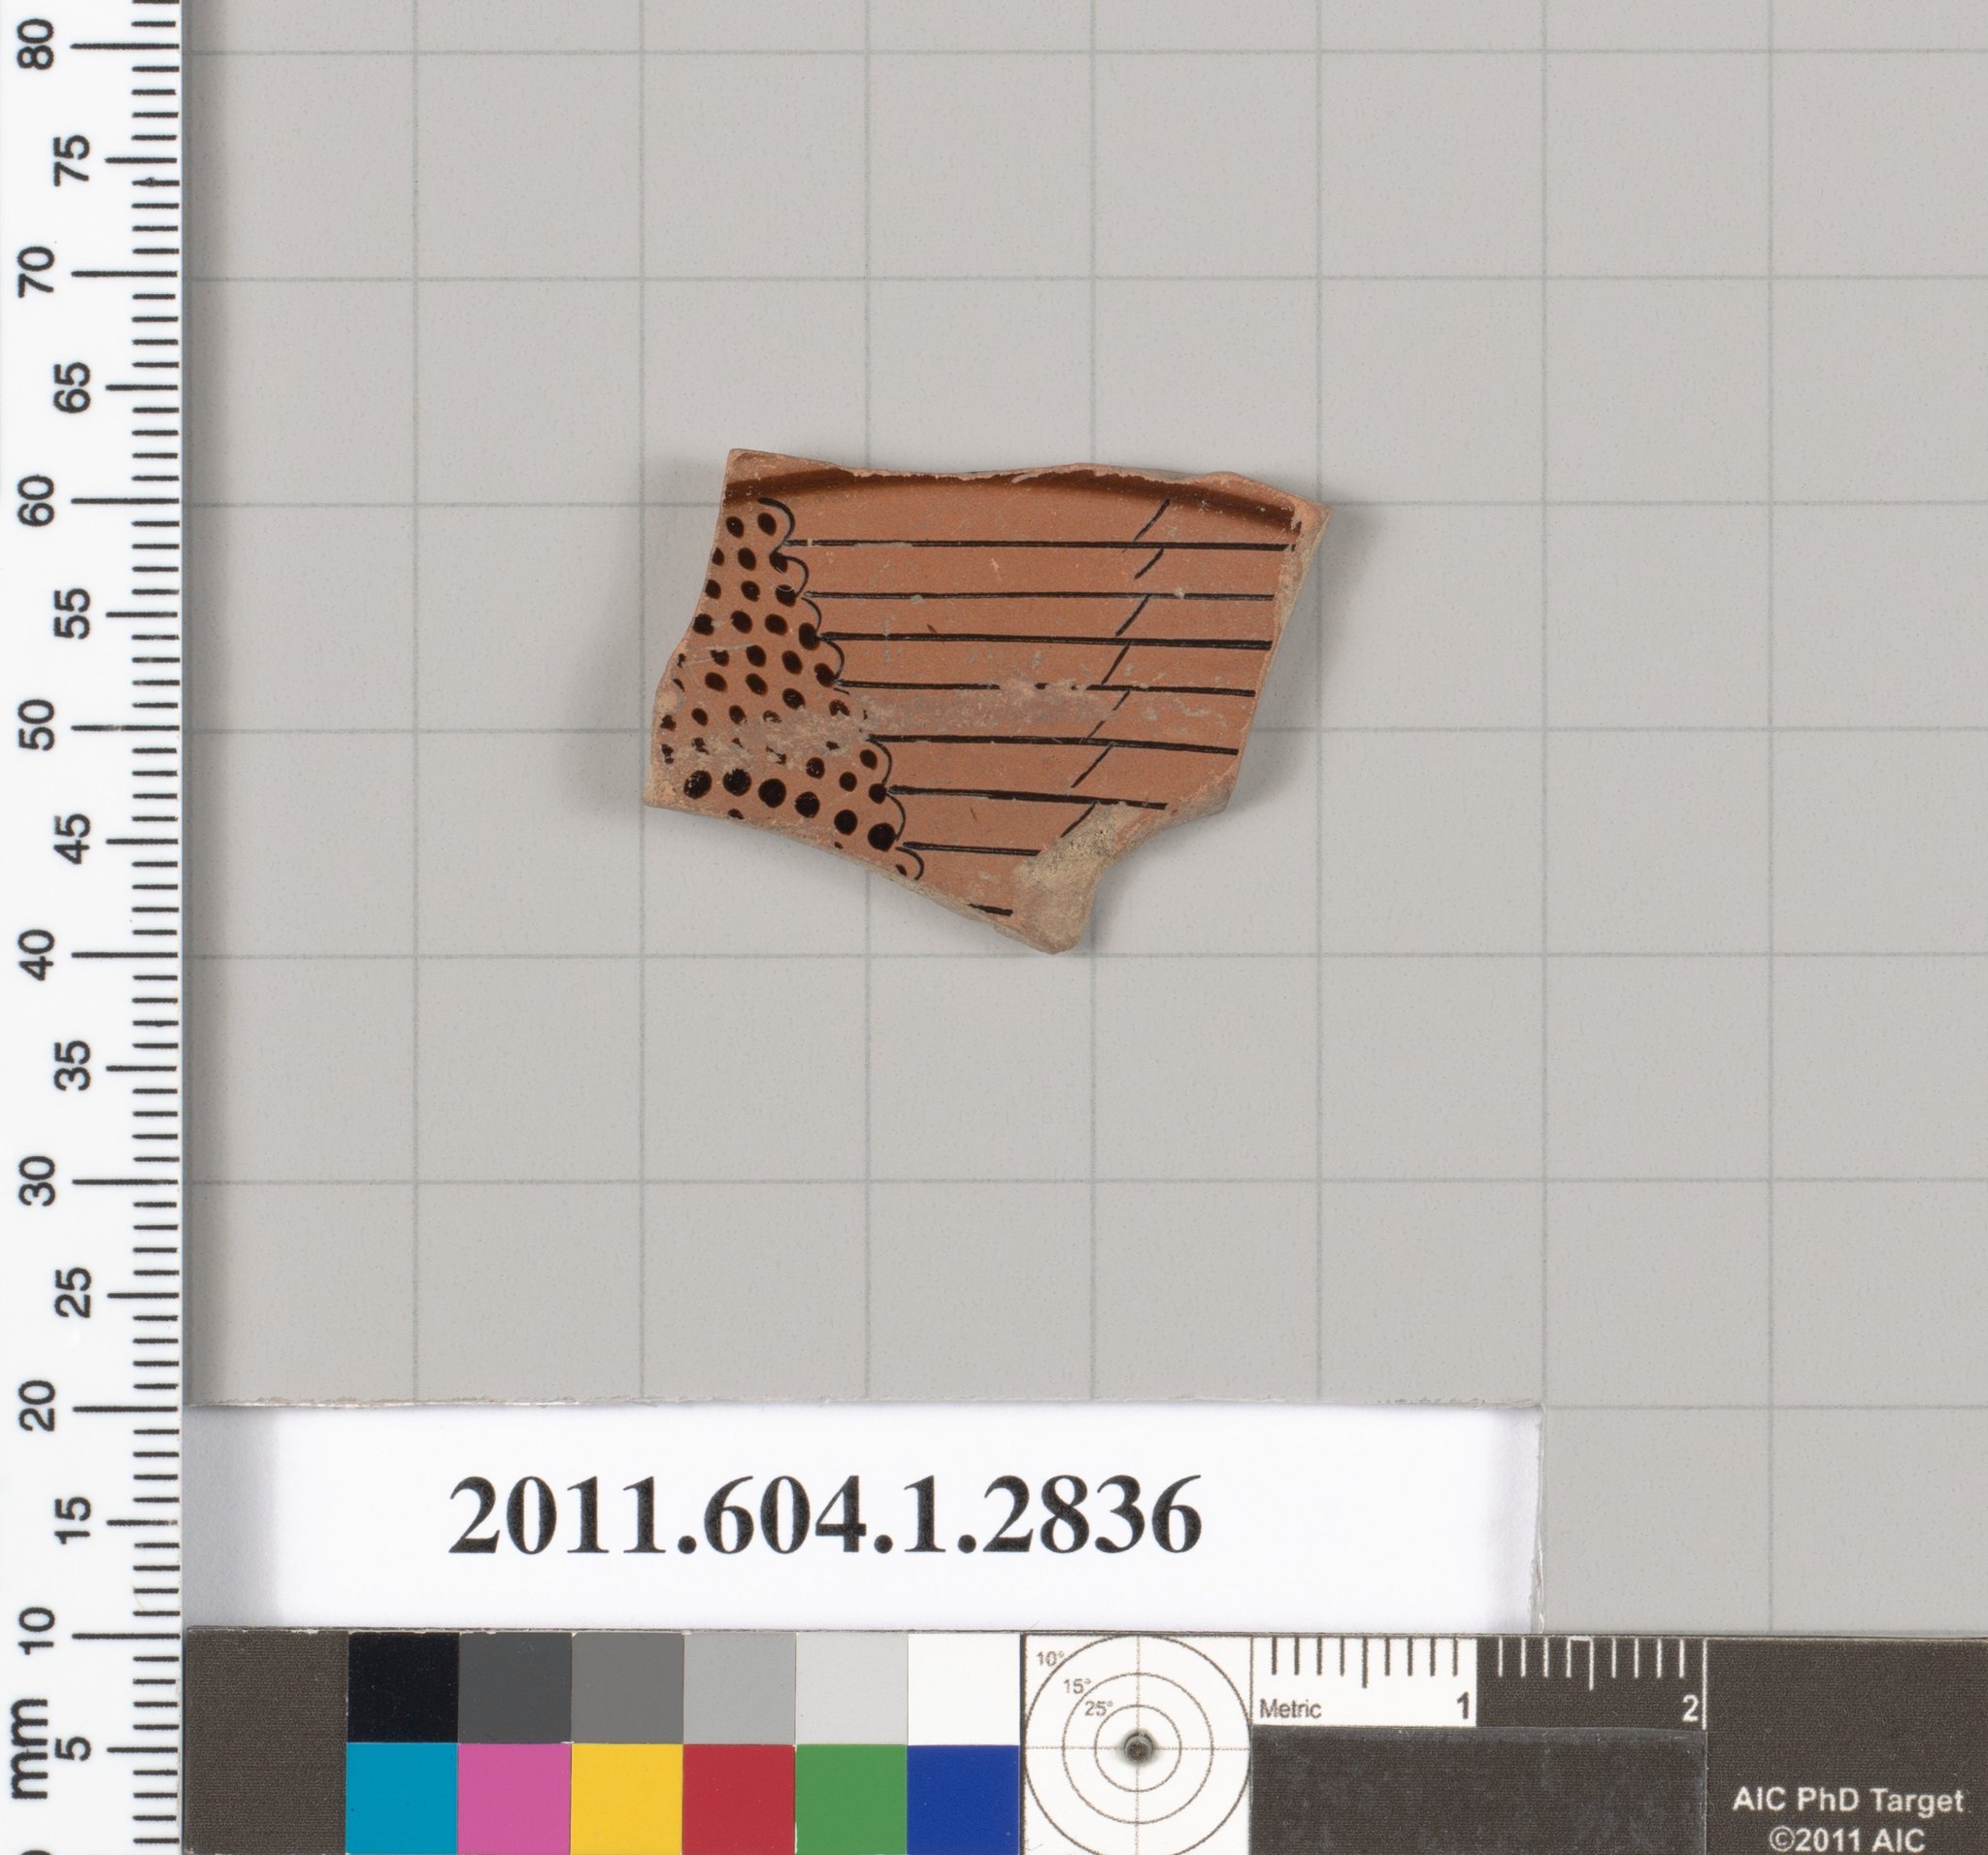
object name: kylix fragment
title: Terracotta fragment of a kylix (drinking cup)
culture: greek, attic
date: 520-490 BCE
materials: terracotta